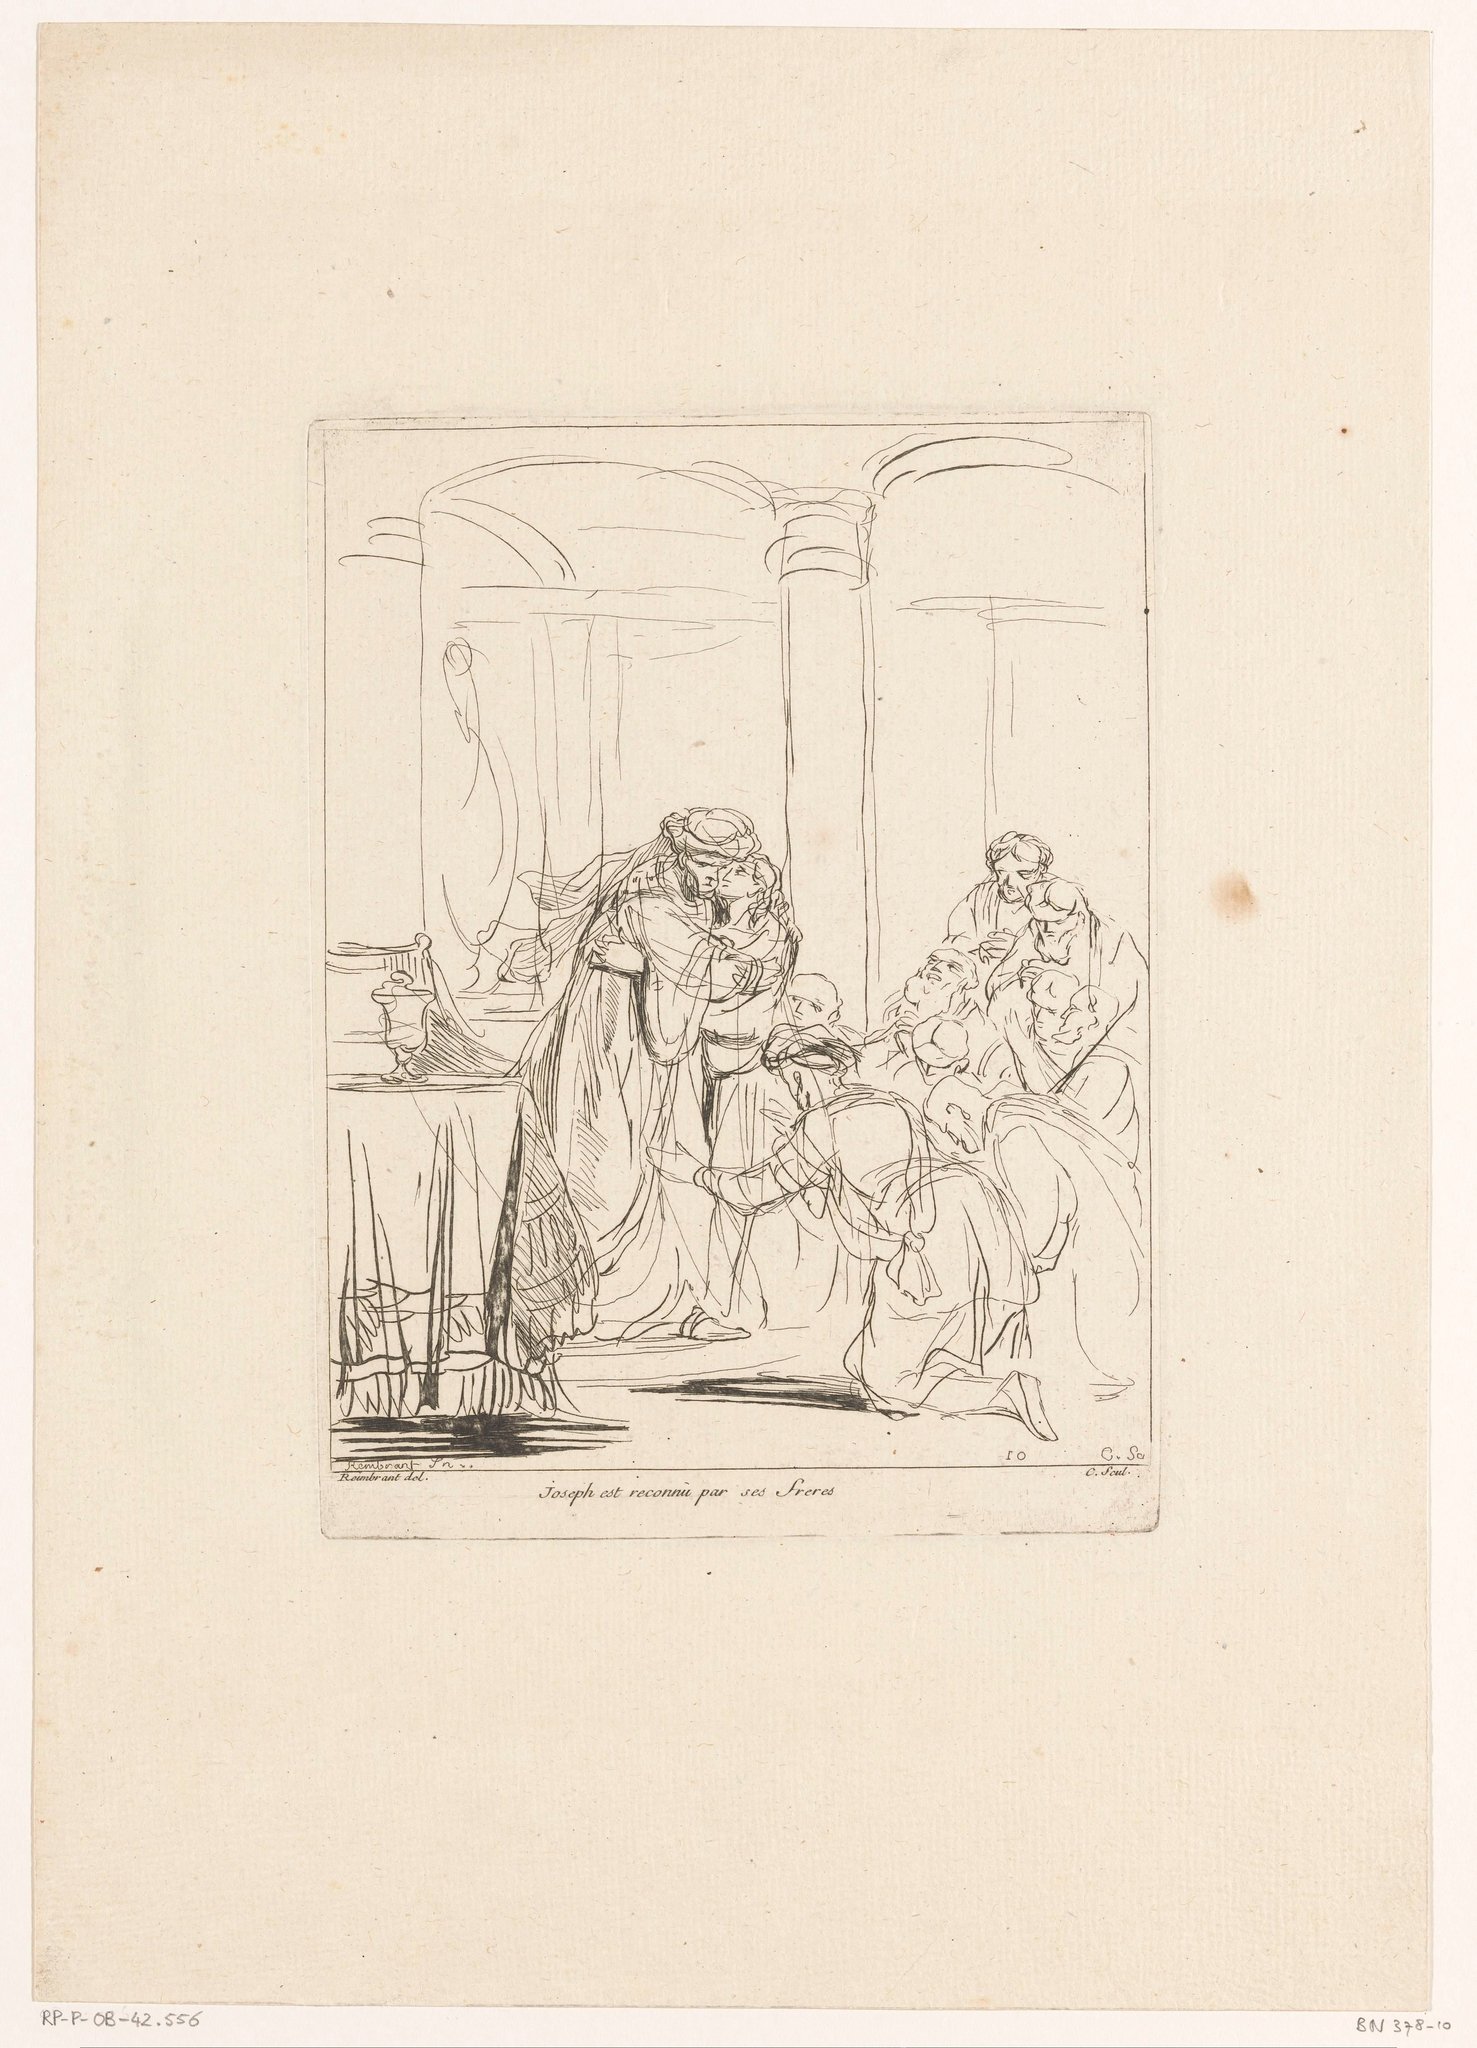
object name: print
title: Jozef maakt zich bekend aan zijn broers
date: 1702-1753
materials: paper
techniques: etching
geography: france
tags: story of joseph (part i), joseph reveals his identity and in tears forgives his brothers' past misdeed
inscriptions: collector's mark: Lugt 240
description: Maakt deel uit van een serie getiteld: "Histoire de Joseph", bestaande uit tien platen naar tekeningen, voorheen toegeschreven aan Rembrandt, maar tegenwoordig gecatalogiseerd als tekeningen in de manier van Rembrandt, waarbij de naam Gerbrandt van den Eeckhout wordt gesuggereerd. De serie wordt genoemd in een veilingcatalogus van Coypel in 1753. In 1757 werd de serie uitgegeven door Jean Néaulme in Amsterdam.